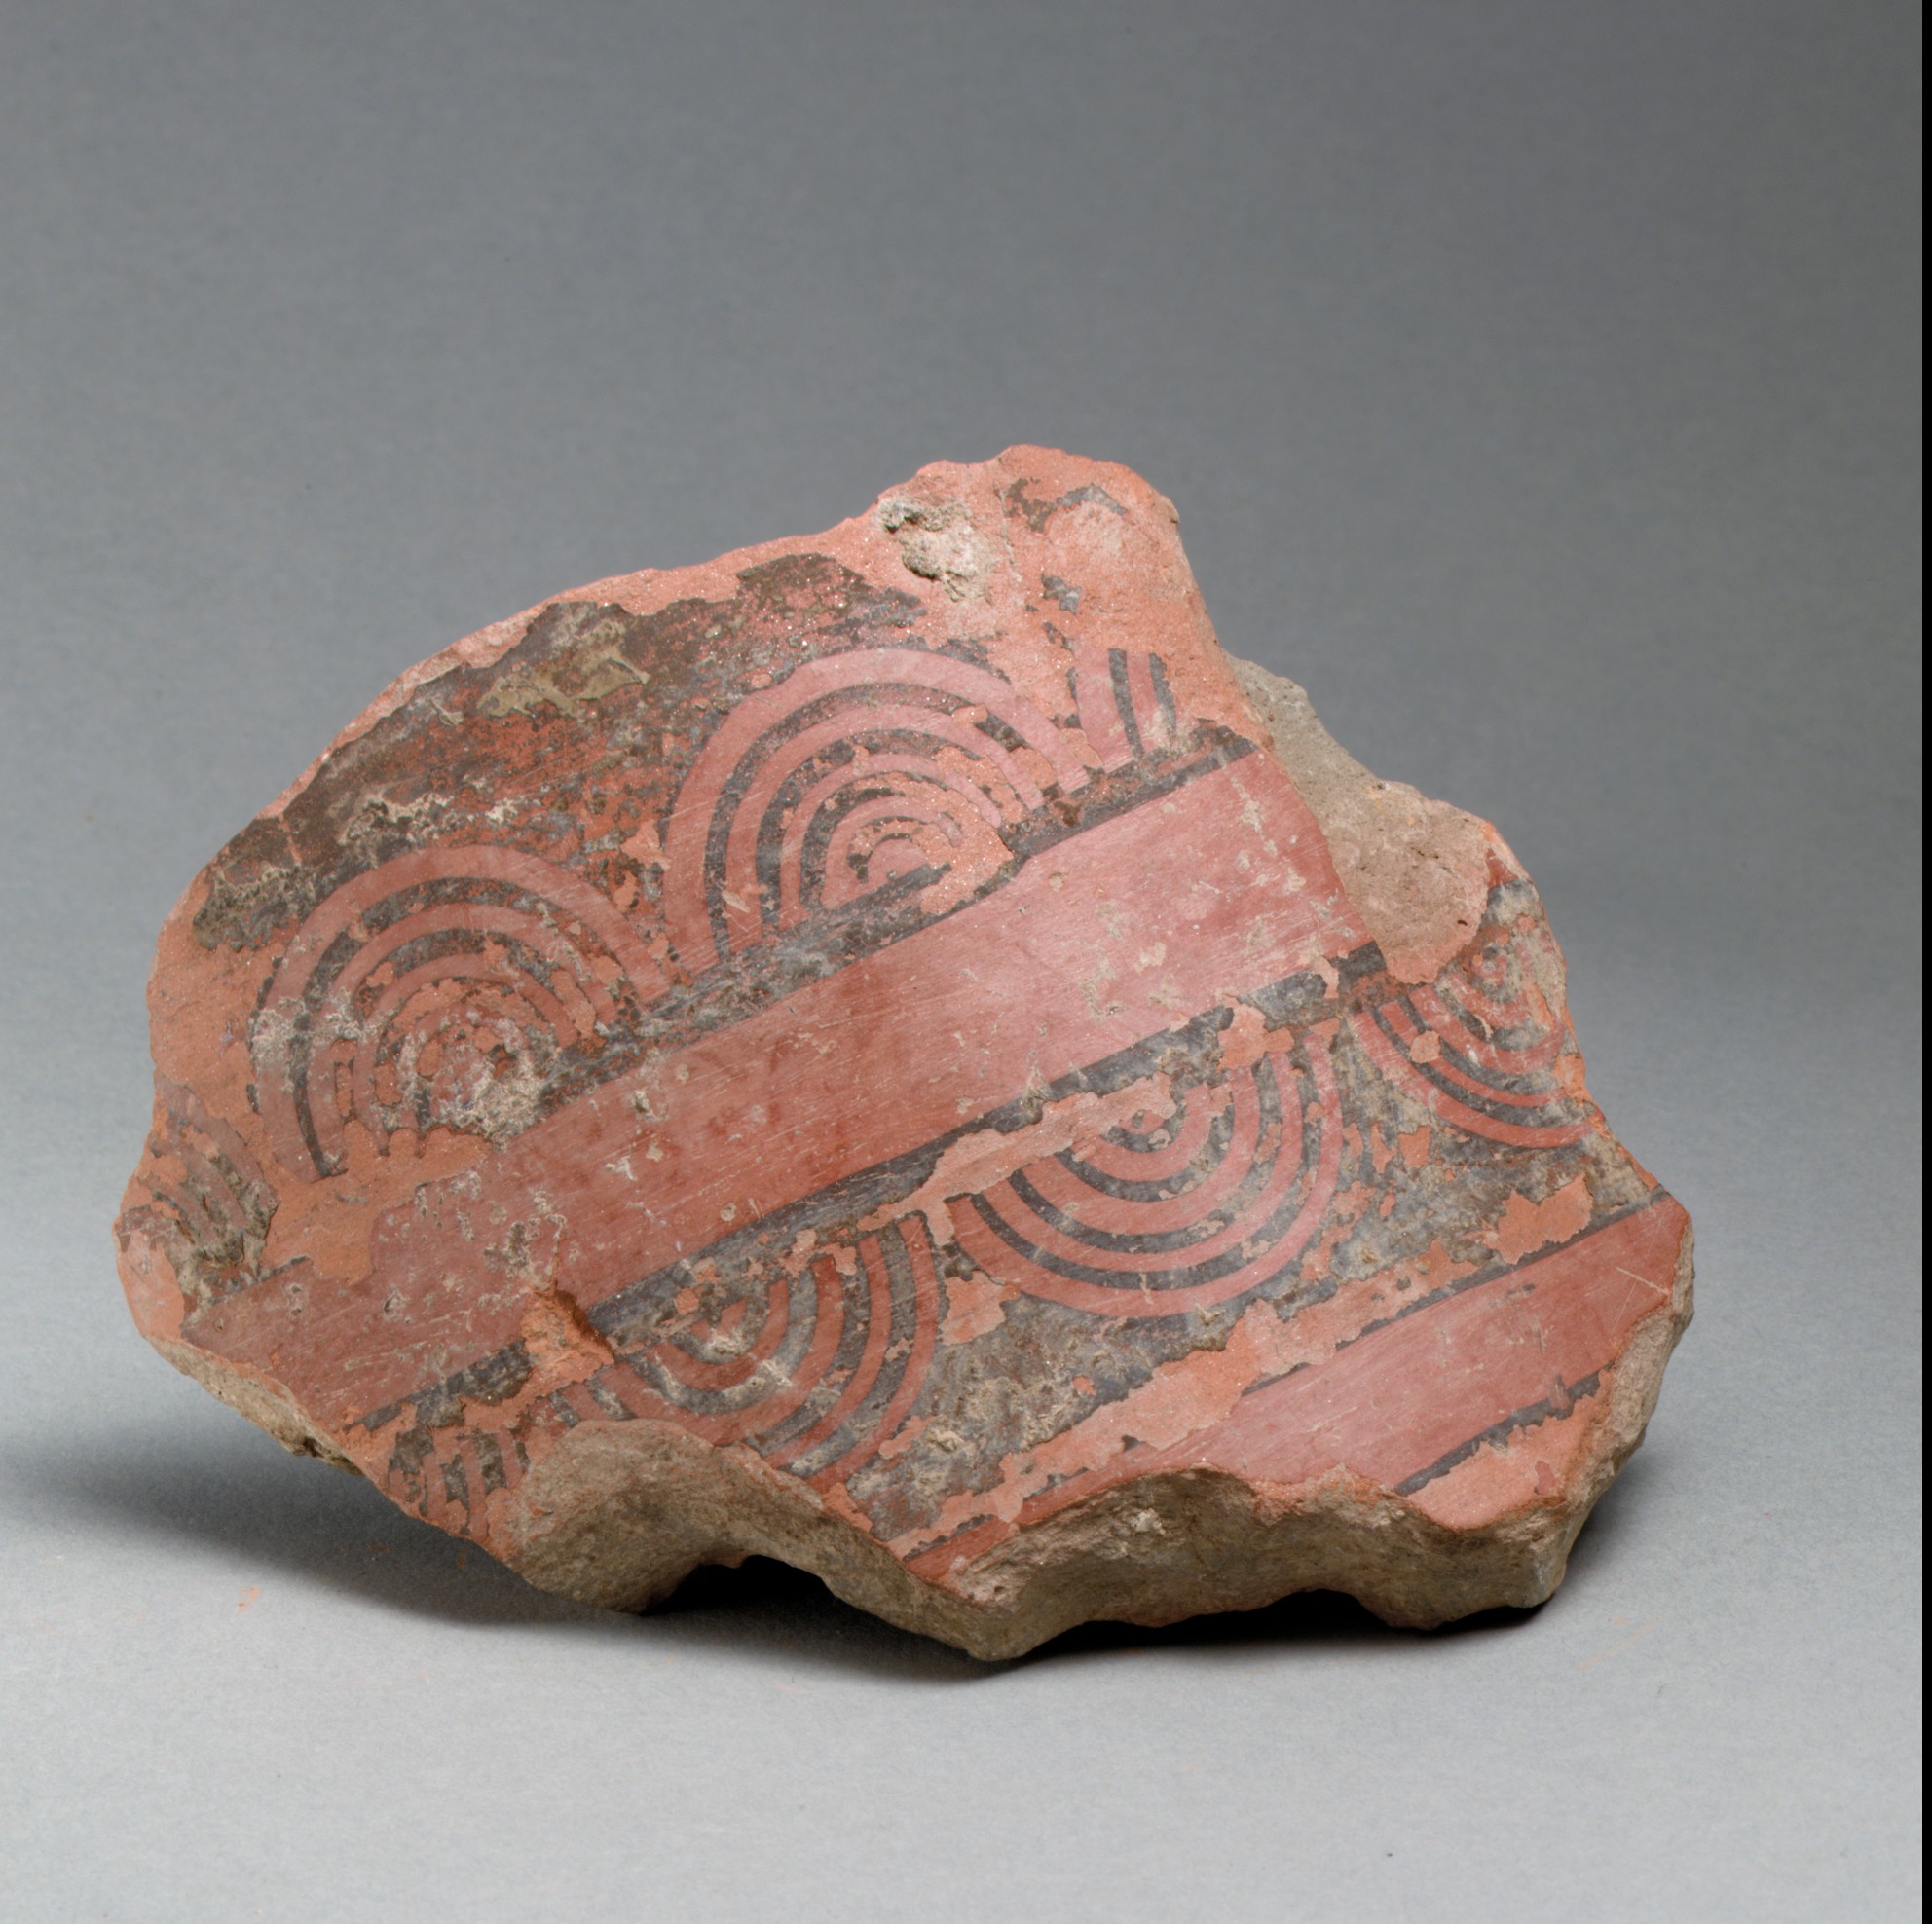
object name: vase fragment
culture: greek or lydian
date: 1050-700 BCE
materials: terracotta